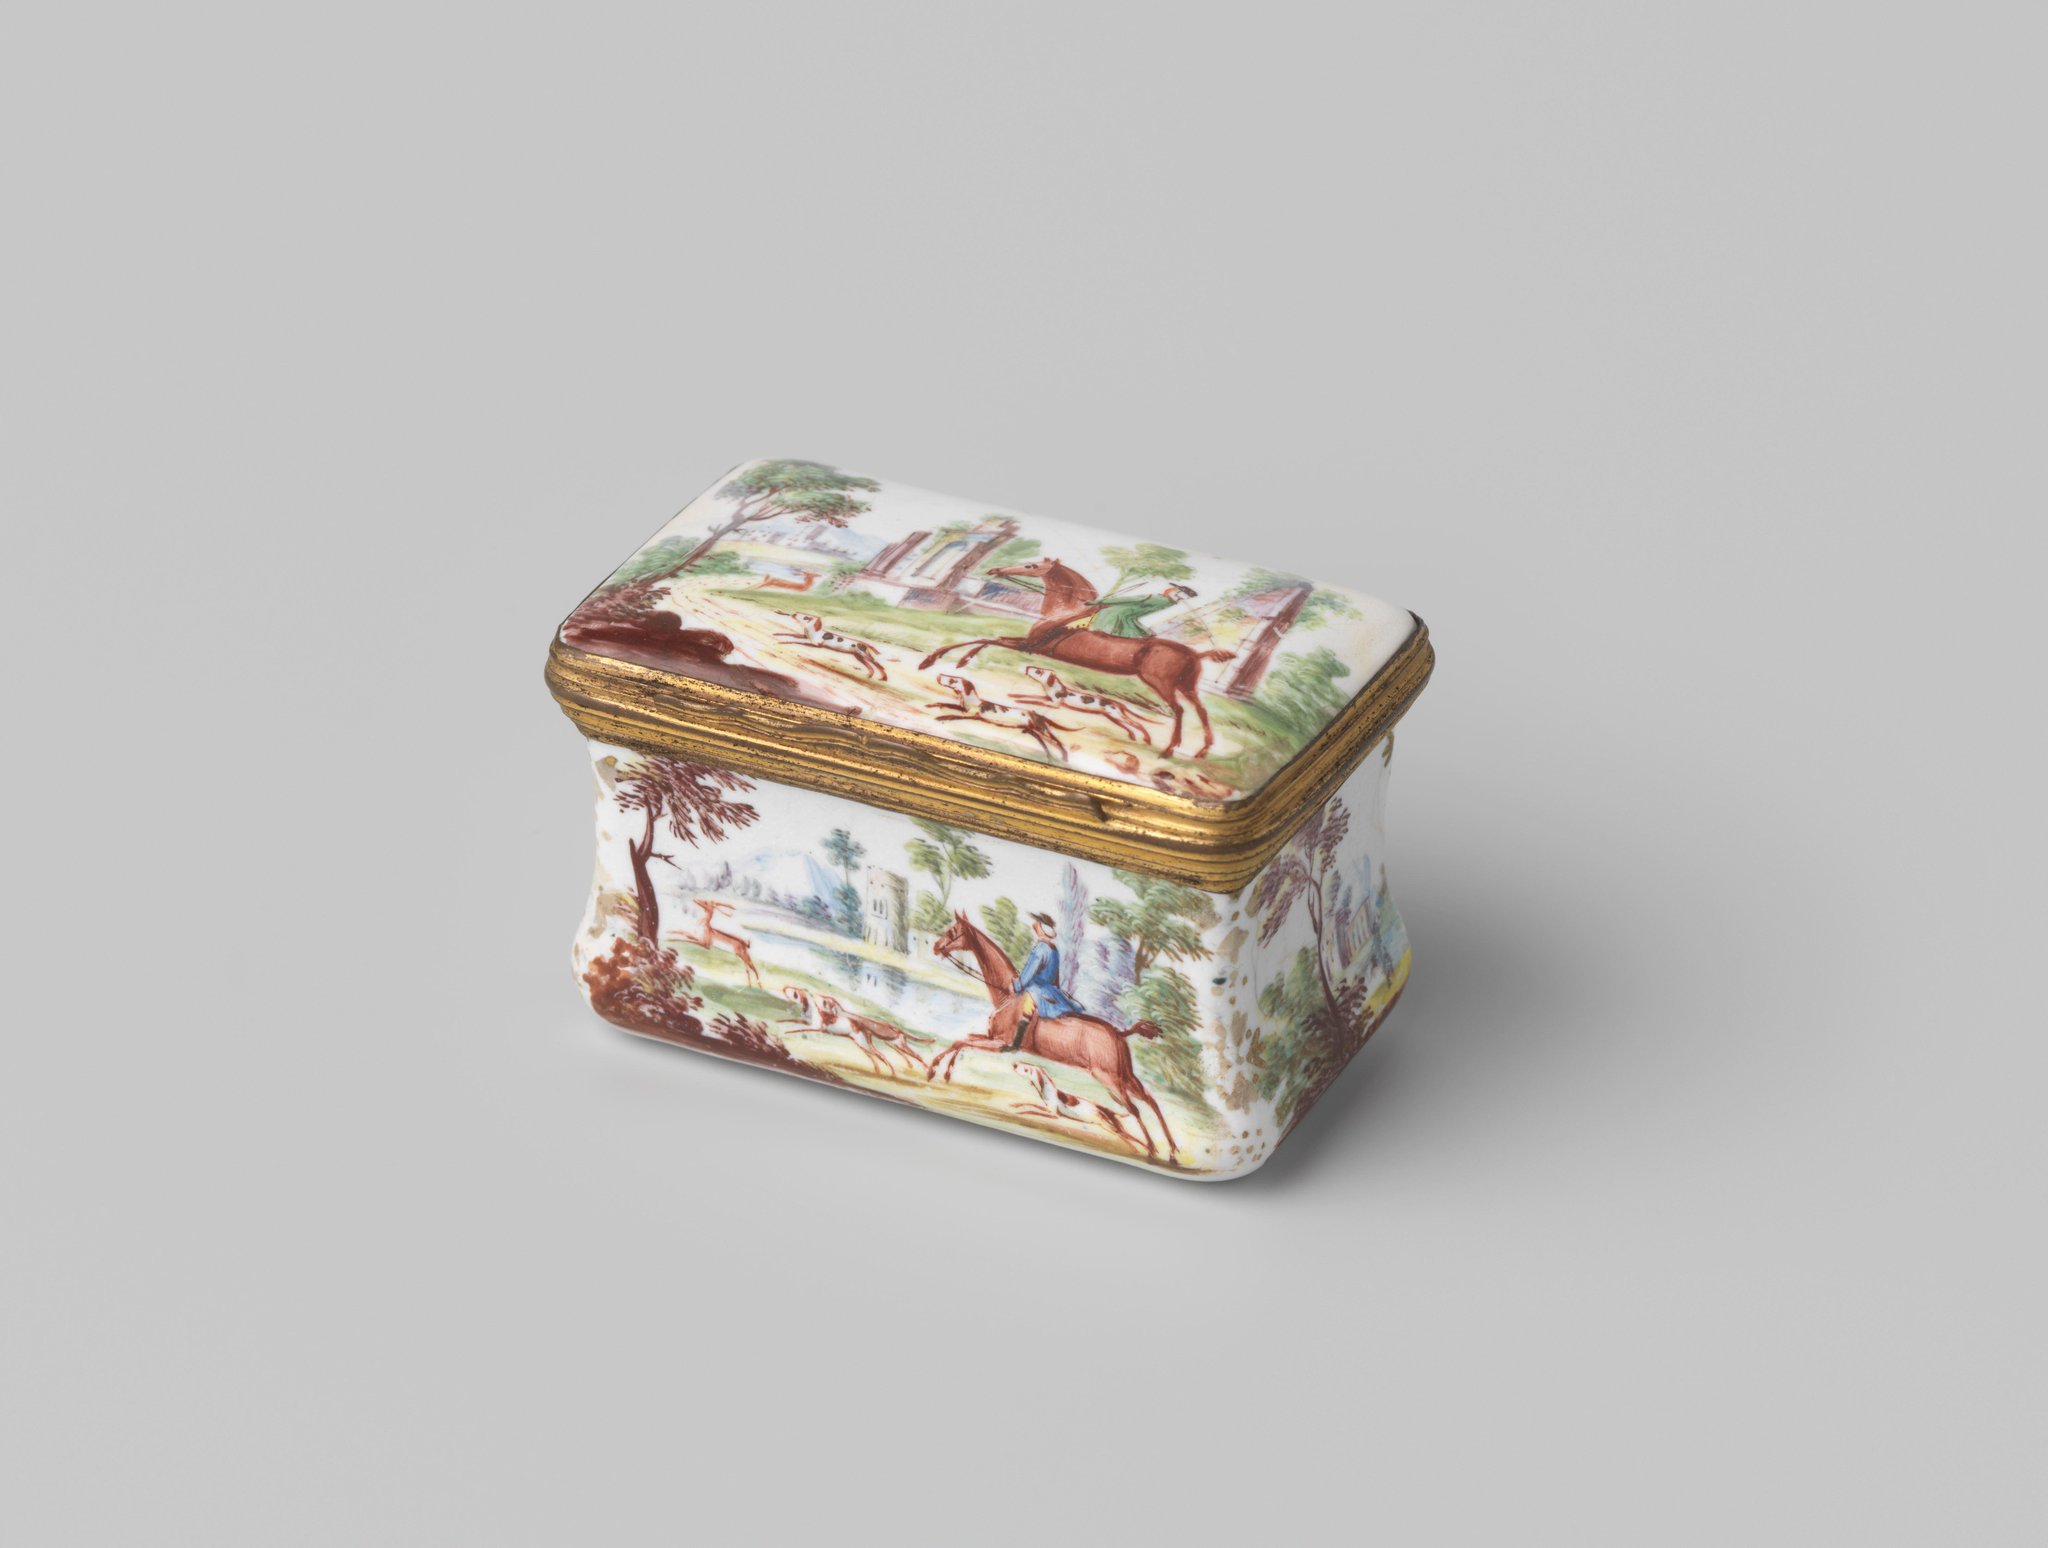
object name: box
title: Snuifdoos, rechthoekig, van geëmailleerd koper met polychrome beschildering met jachtscènes.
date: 1790-1800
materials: copper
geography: battersea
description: Snuifdoos, rechthoekig, van geëmailleerd koper met polychrome beschildering met jachtscènes.